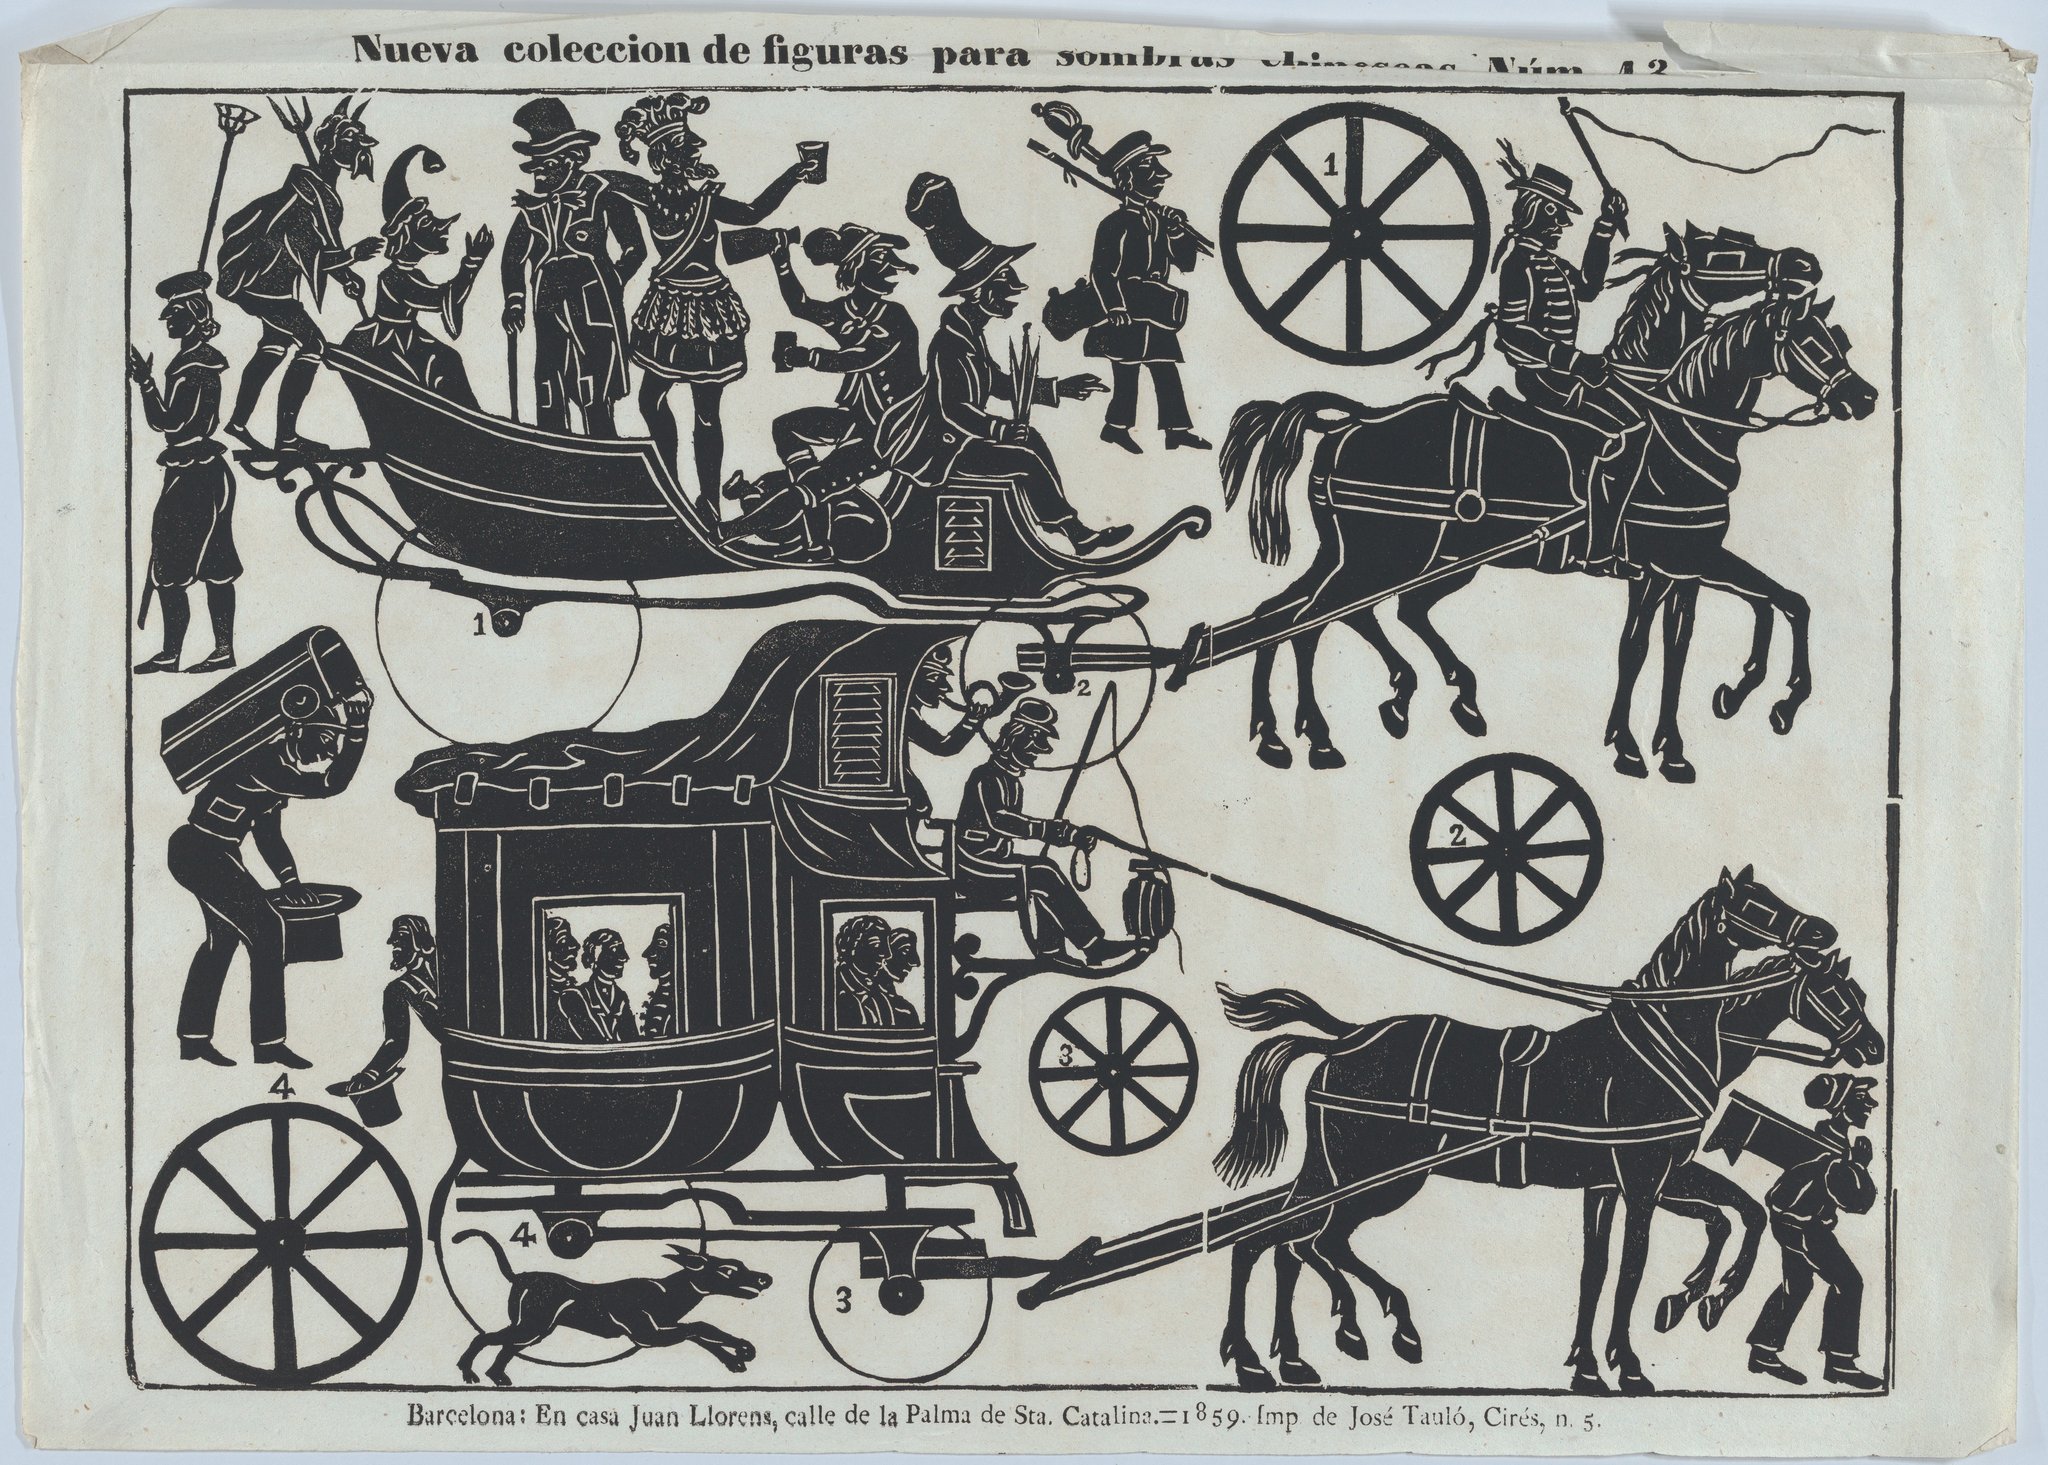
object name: print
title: Sheet 13 of figures for Chinese shadow puppets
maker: juan llorens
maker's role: publisher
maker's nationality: spanish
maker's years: 1800-1900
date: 1859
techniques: engraving, woodcut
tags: men,women,horses,carriages,puppets